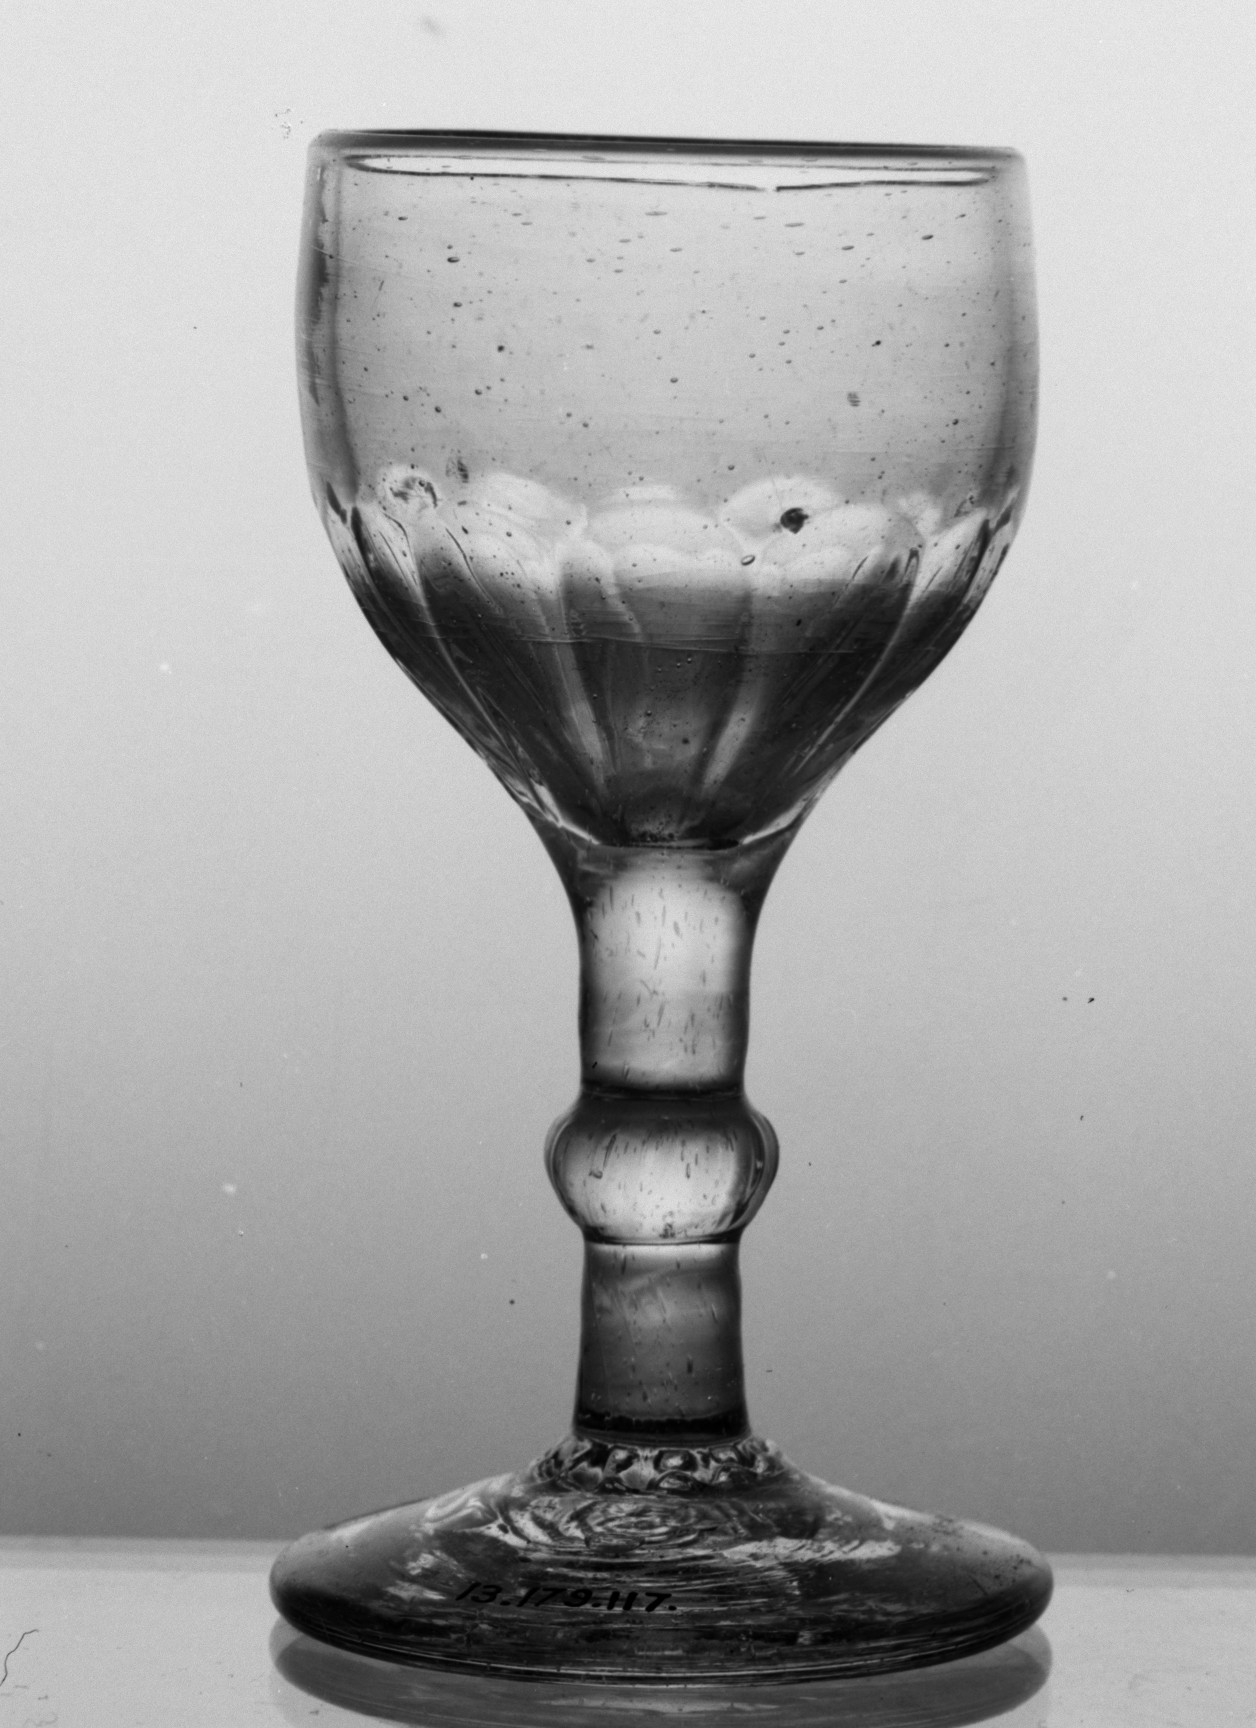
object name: cordial glass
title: Cordial glasses (3)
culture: provincial british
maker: henry william stiegel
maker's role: former attribution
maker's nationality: american, born germany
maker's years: 1729-1785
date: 1701-1800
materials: glass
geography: united states